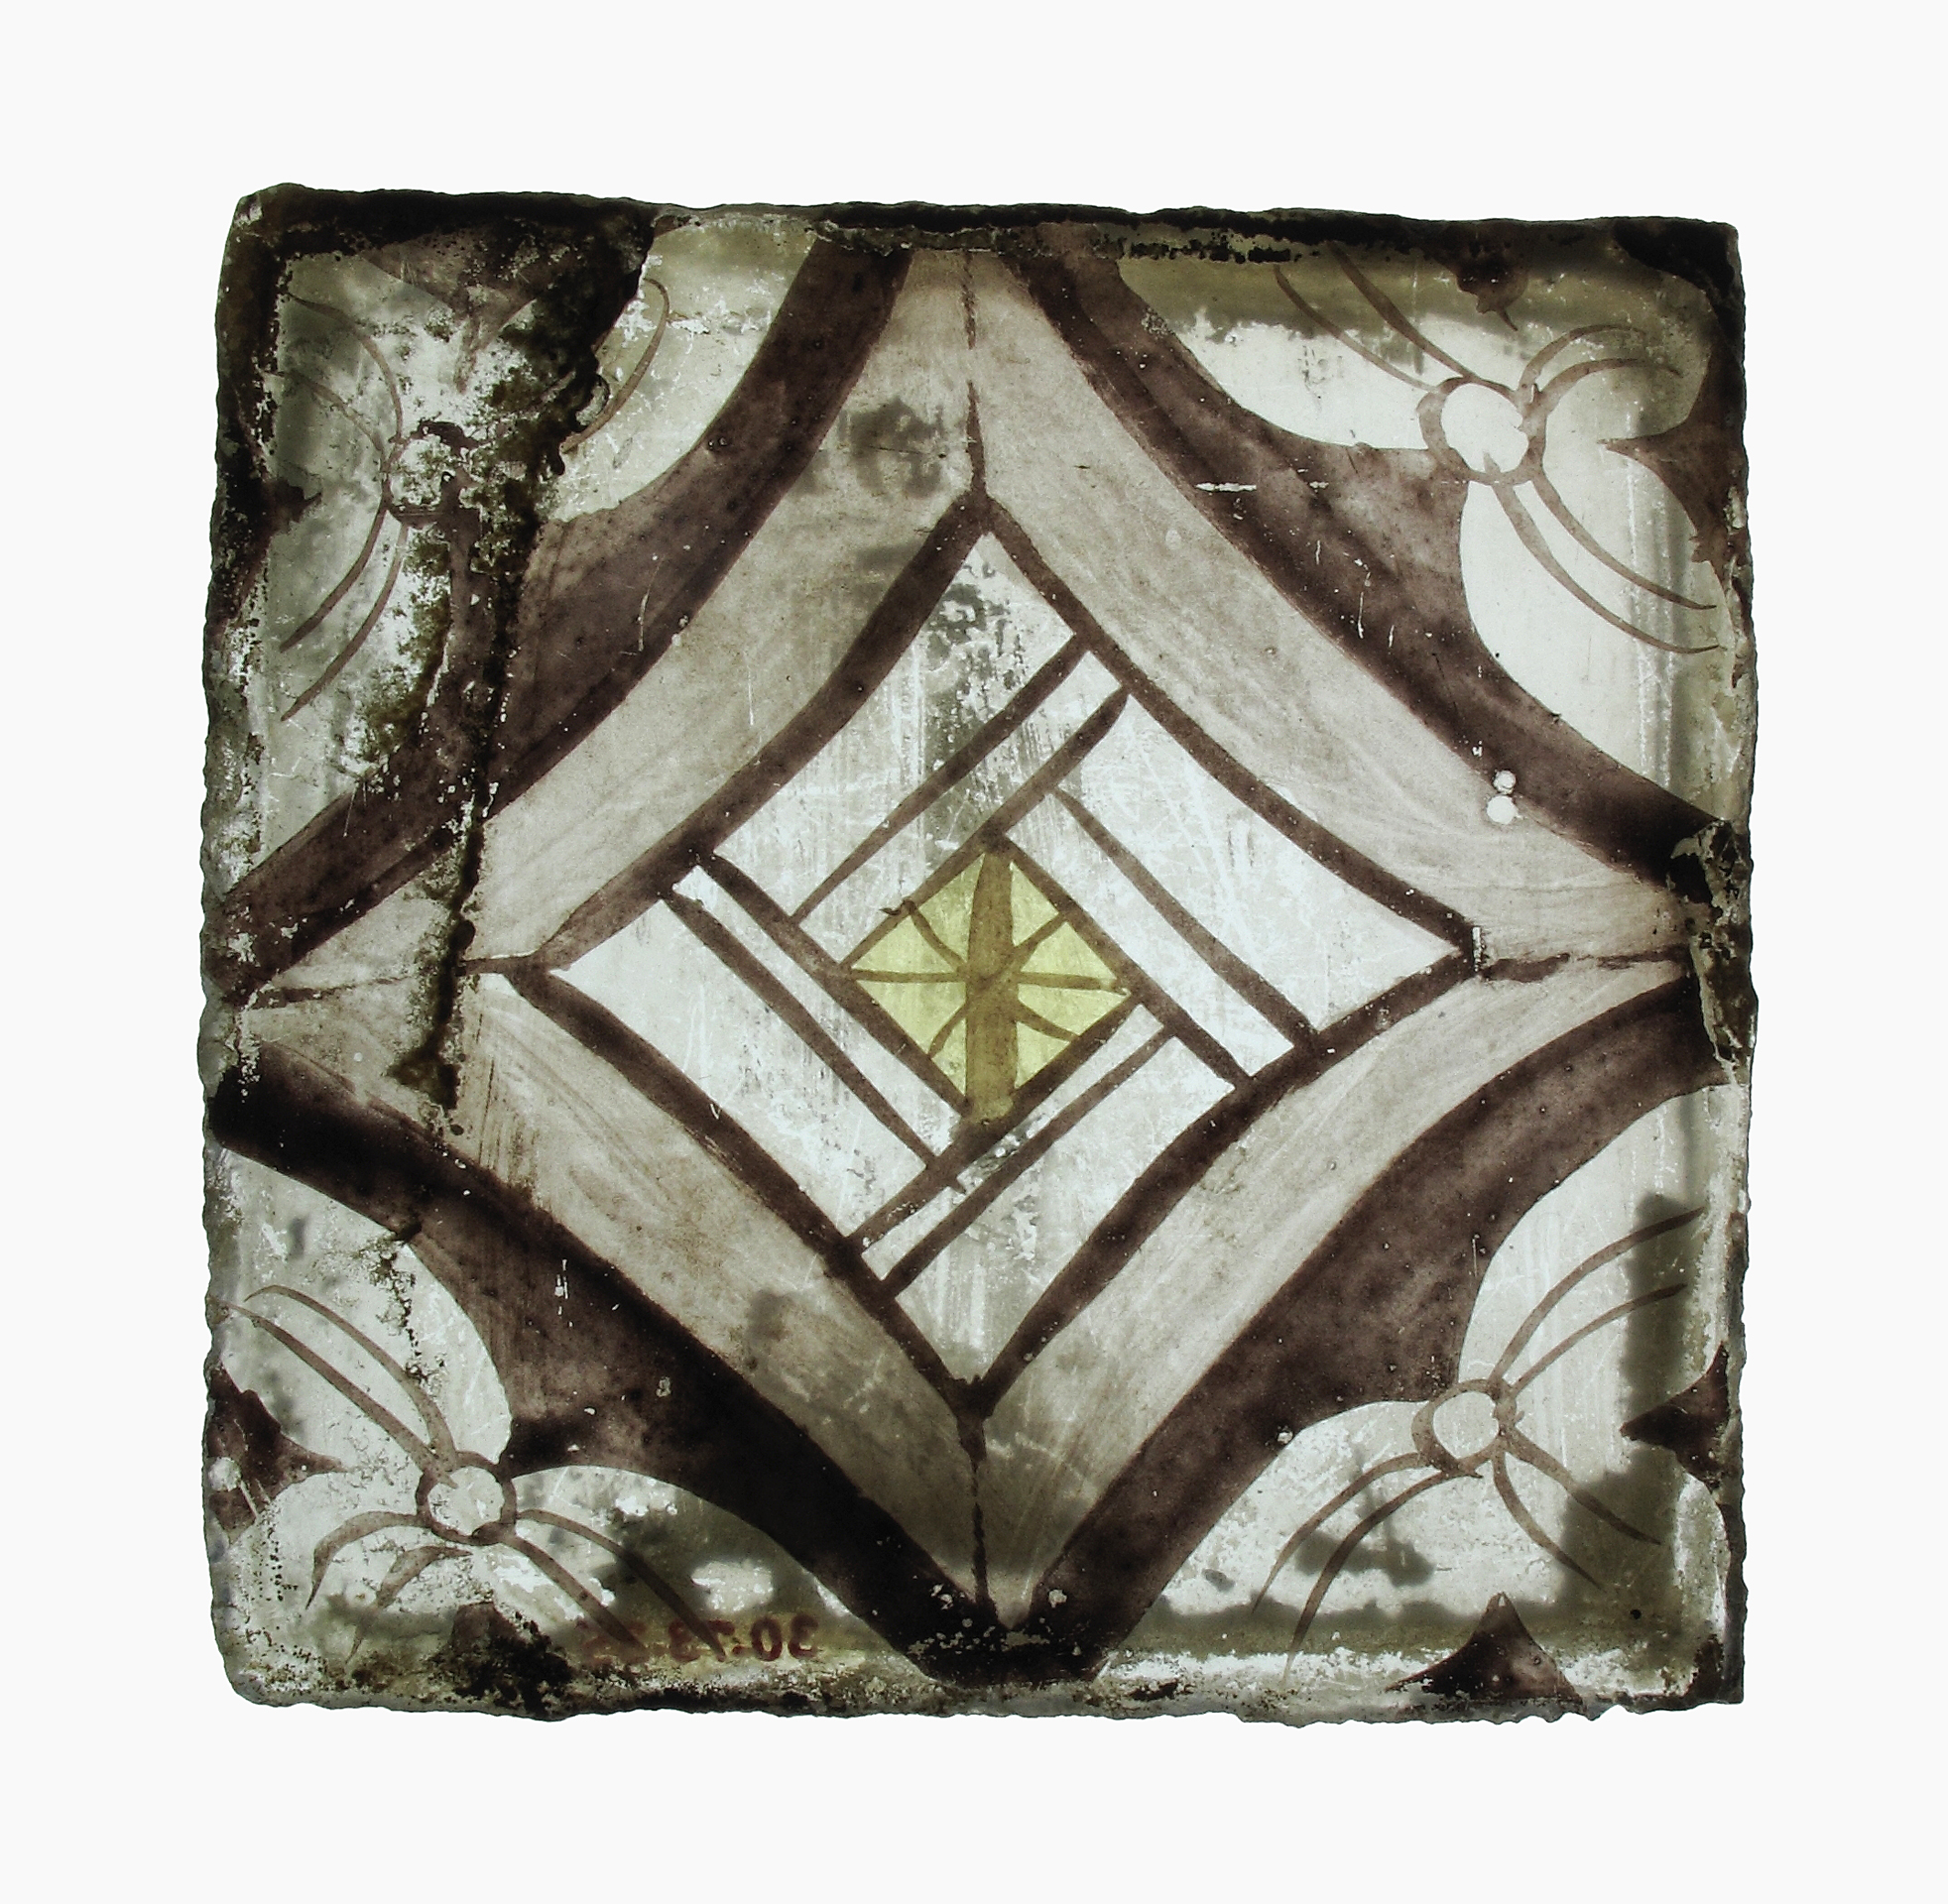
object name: fragment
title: Glass Fragment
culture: european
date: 1401-1500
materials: glass